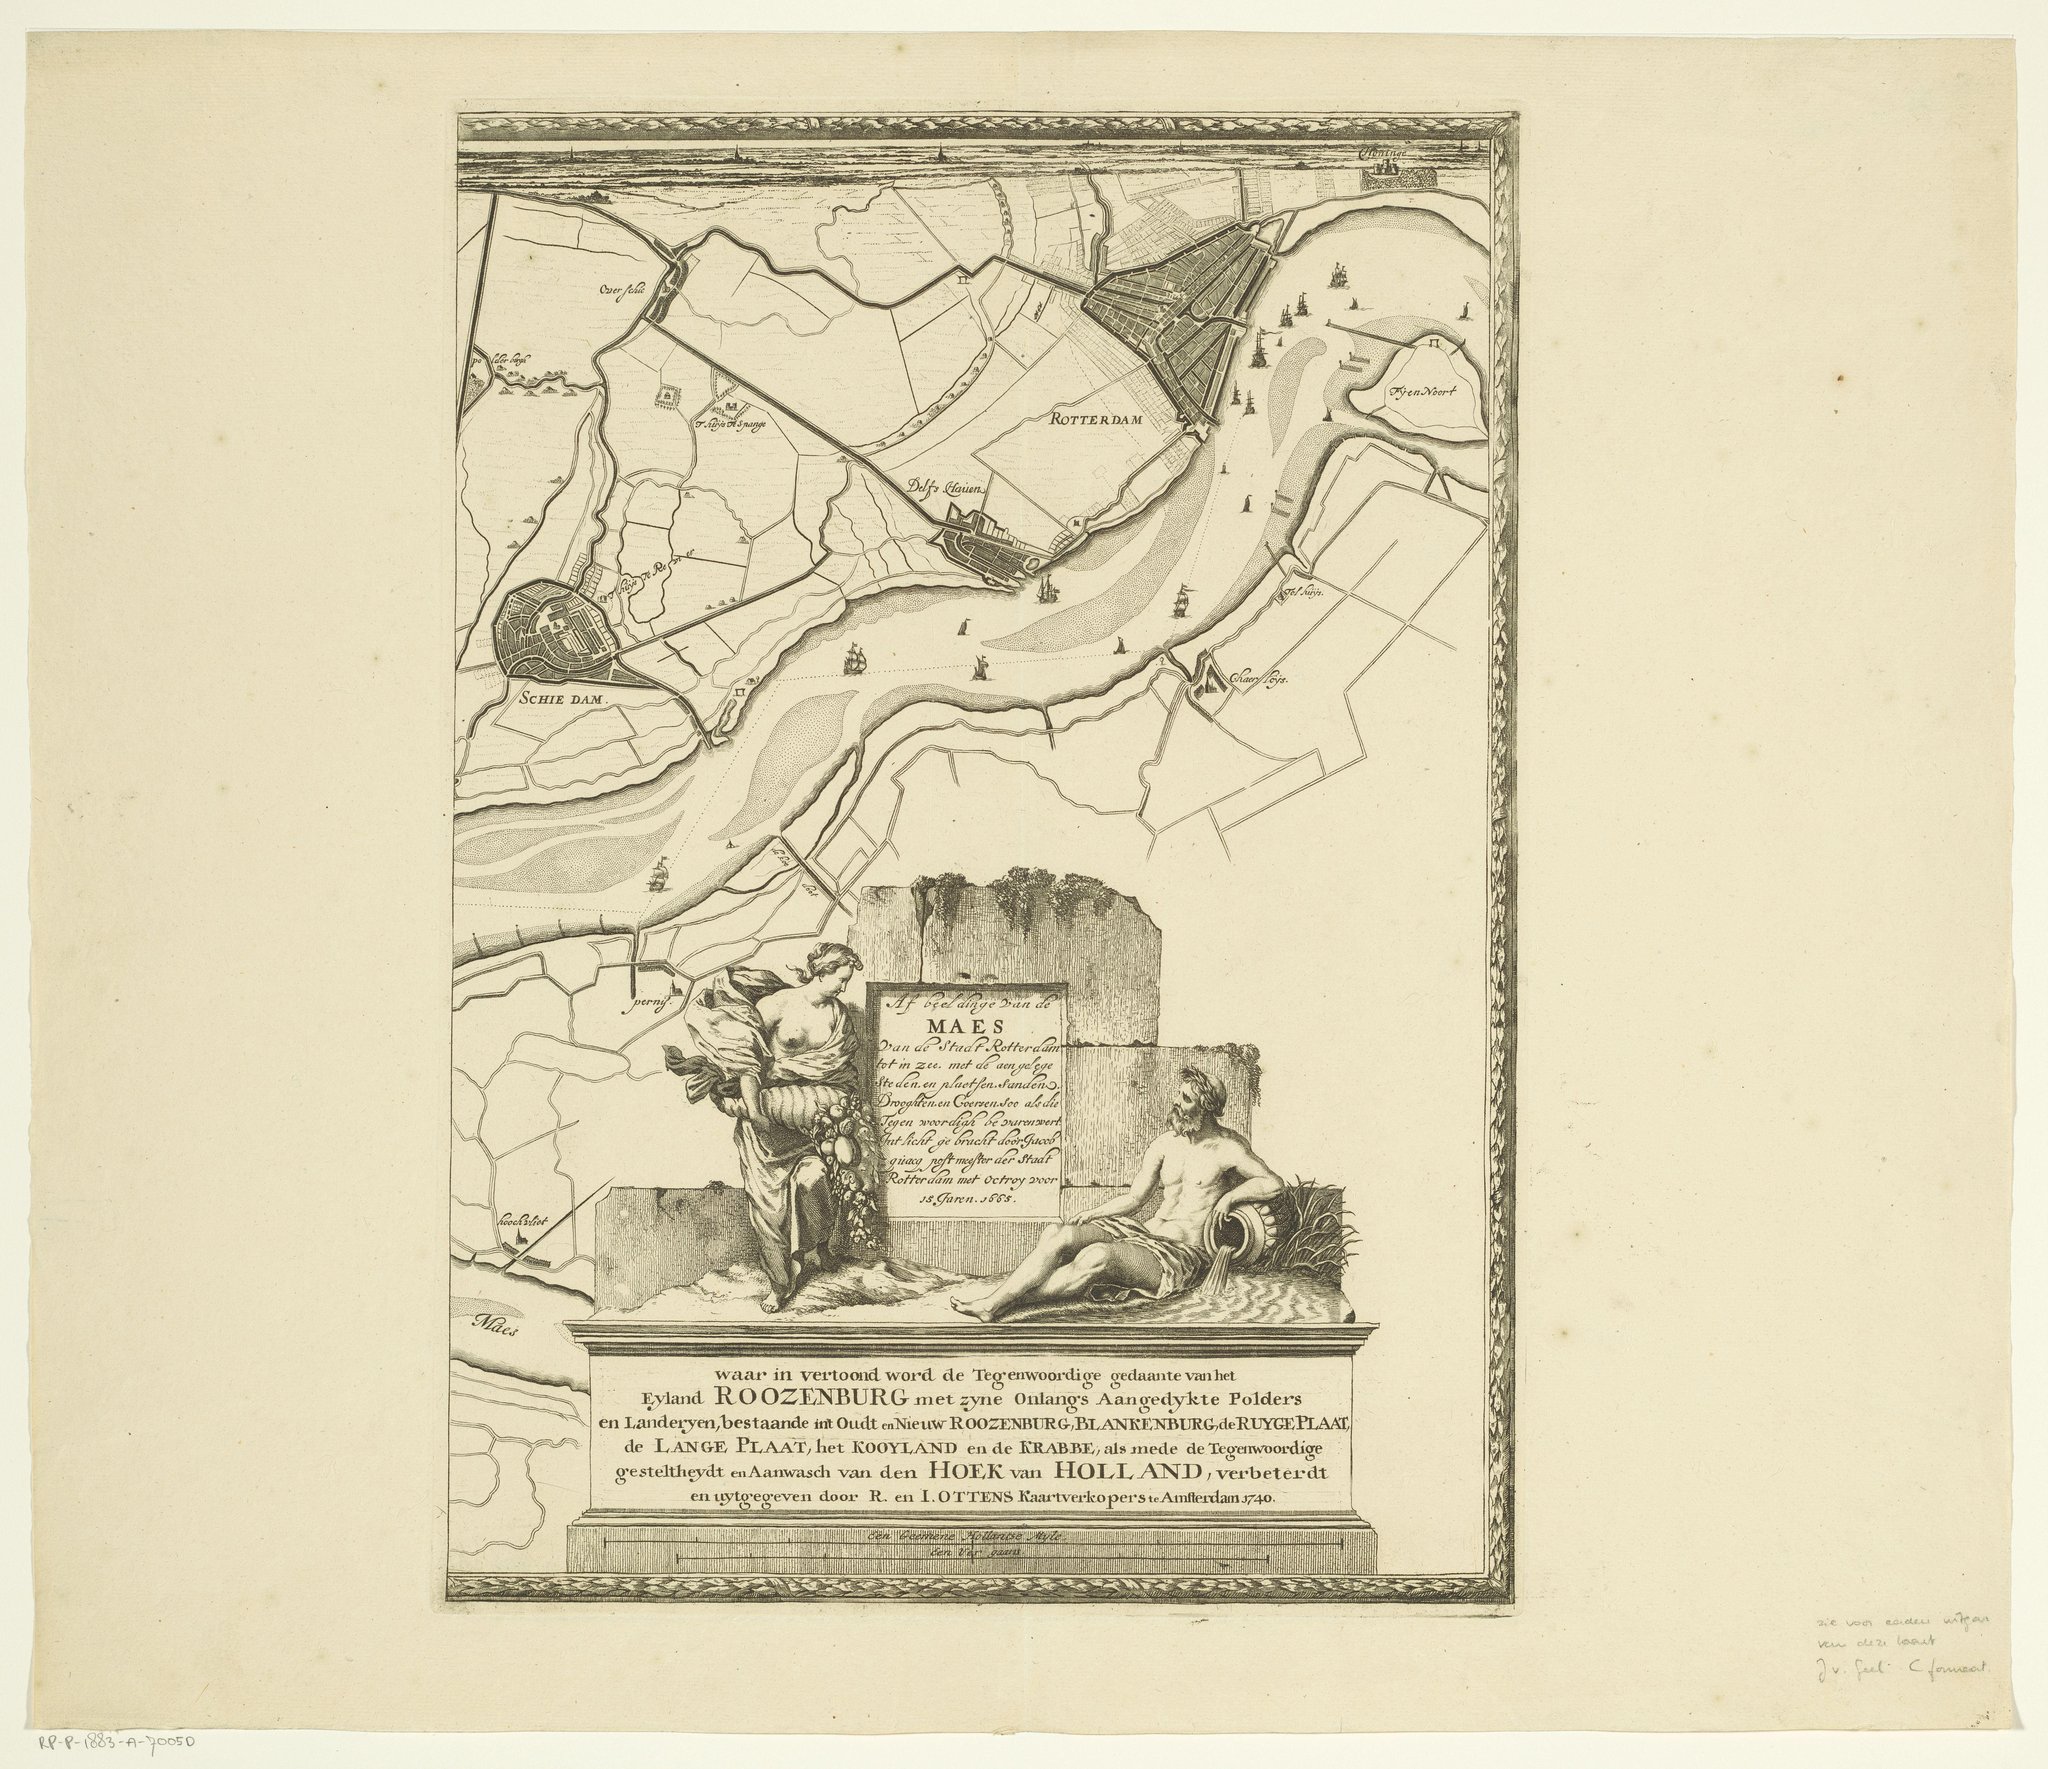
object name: print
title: Afbeeldinge van de Maes van de stadt Rotterdam tot in zee, met de aengelege steden, en plaetsen, sanden, drooghten, en coersen, soo als die tegen woordigh bevaren wert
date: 1666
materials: paper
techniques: engraving, etching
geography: amsterdam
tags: 'cornucopia', horn of plenty, maps of separate countries or regions, river-gods, maps of cities, delfshaven, rotterdam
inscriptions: collector's mark: Lugt 2228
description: De eerste staat van deze prent is oorspronkelijk bedoeld als onderdeel van de zogenaamde Maaskaart uit 1666, verschenen onder de titel 'Rotterodamum Hollandiae urbs celeberrima et situ portibusque mercaturae opportunissima. Ao. 1665'. Hoewel het jaartal 1665 in de titel stond, blijkt uit archiefonderzoek dat de kaart pas in 1666 gereed was (zie documentatie). Zie ook RP-P-AO-13-5 voor meer informatie.